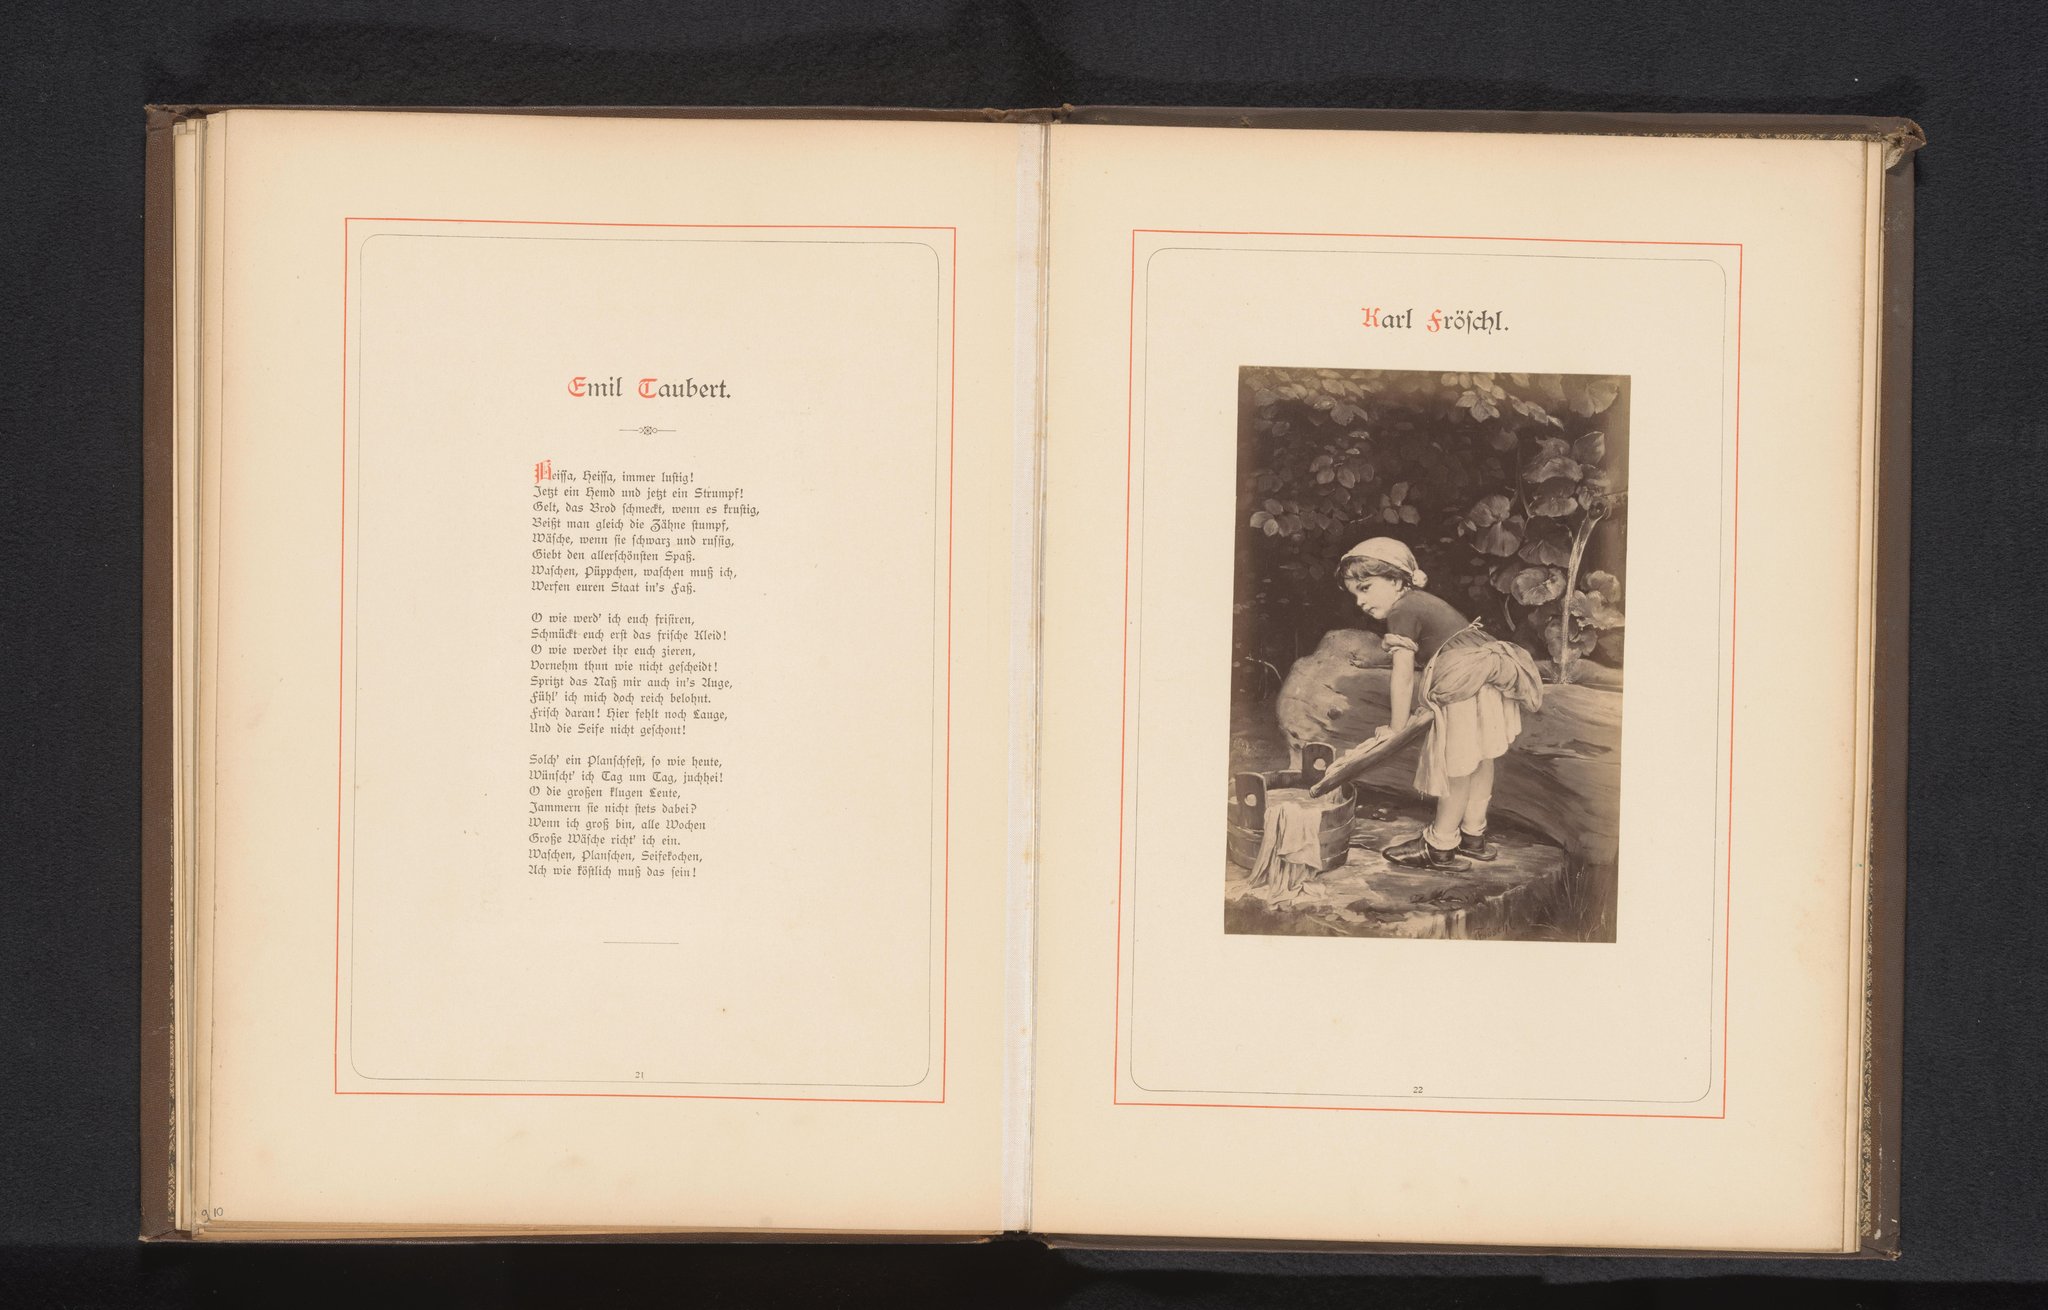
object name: photograph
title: Fotoreproductie van een schilderij door Carl Fröschl, voorstellende een meisje bij een wastobbe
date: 1875-1885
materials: photographic support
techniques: albumen print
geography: munich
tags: picture, painting, building or outbuilding where laundry is done